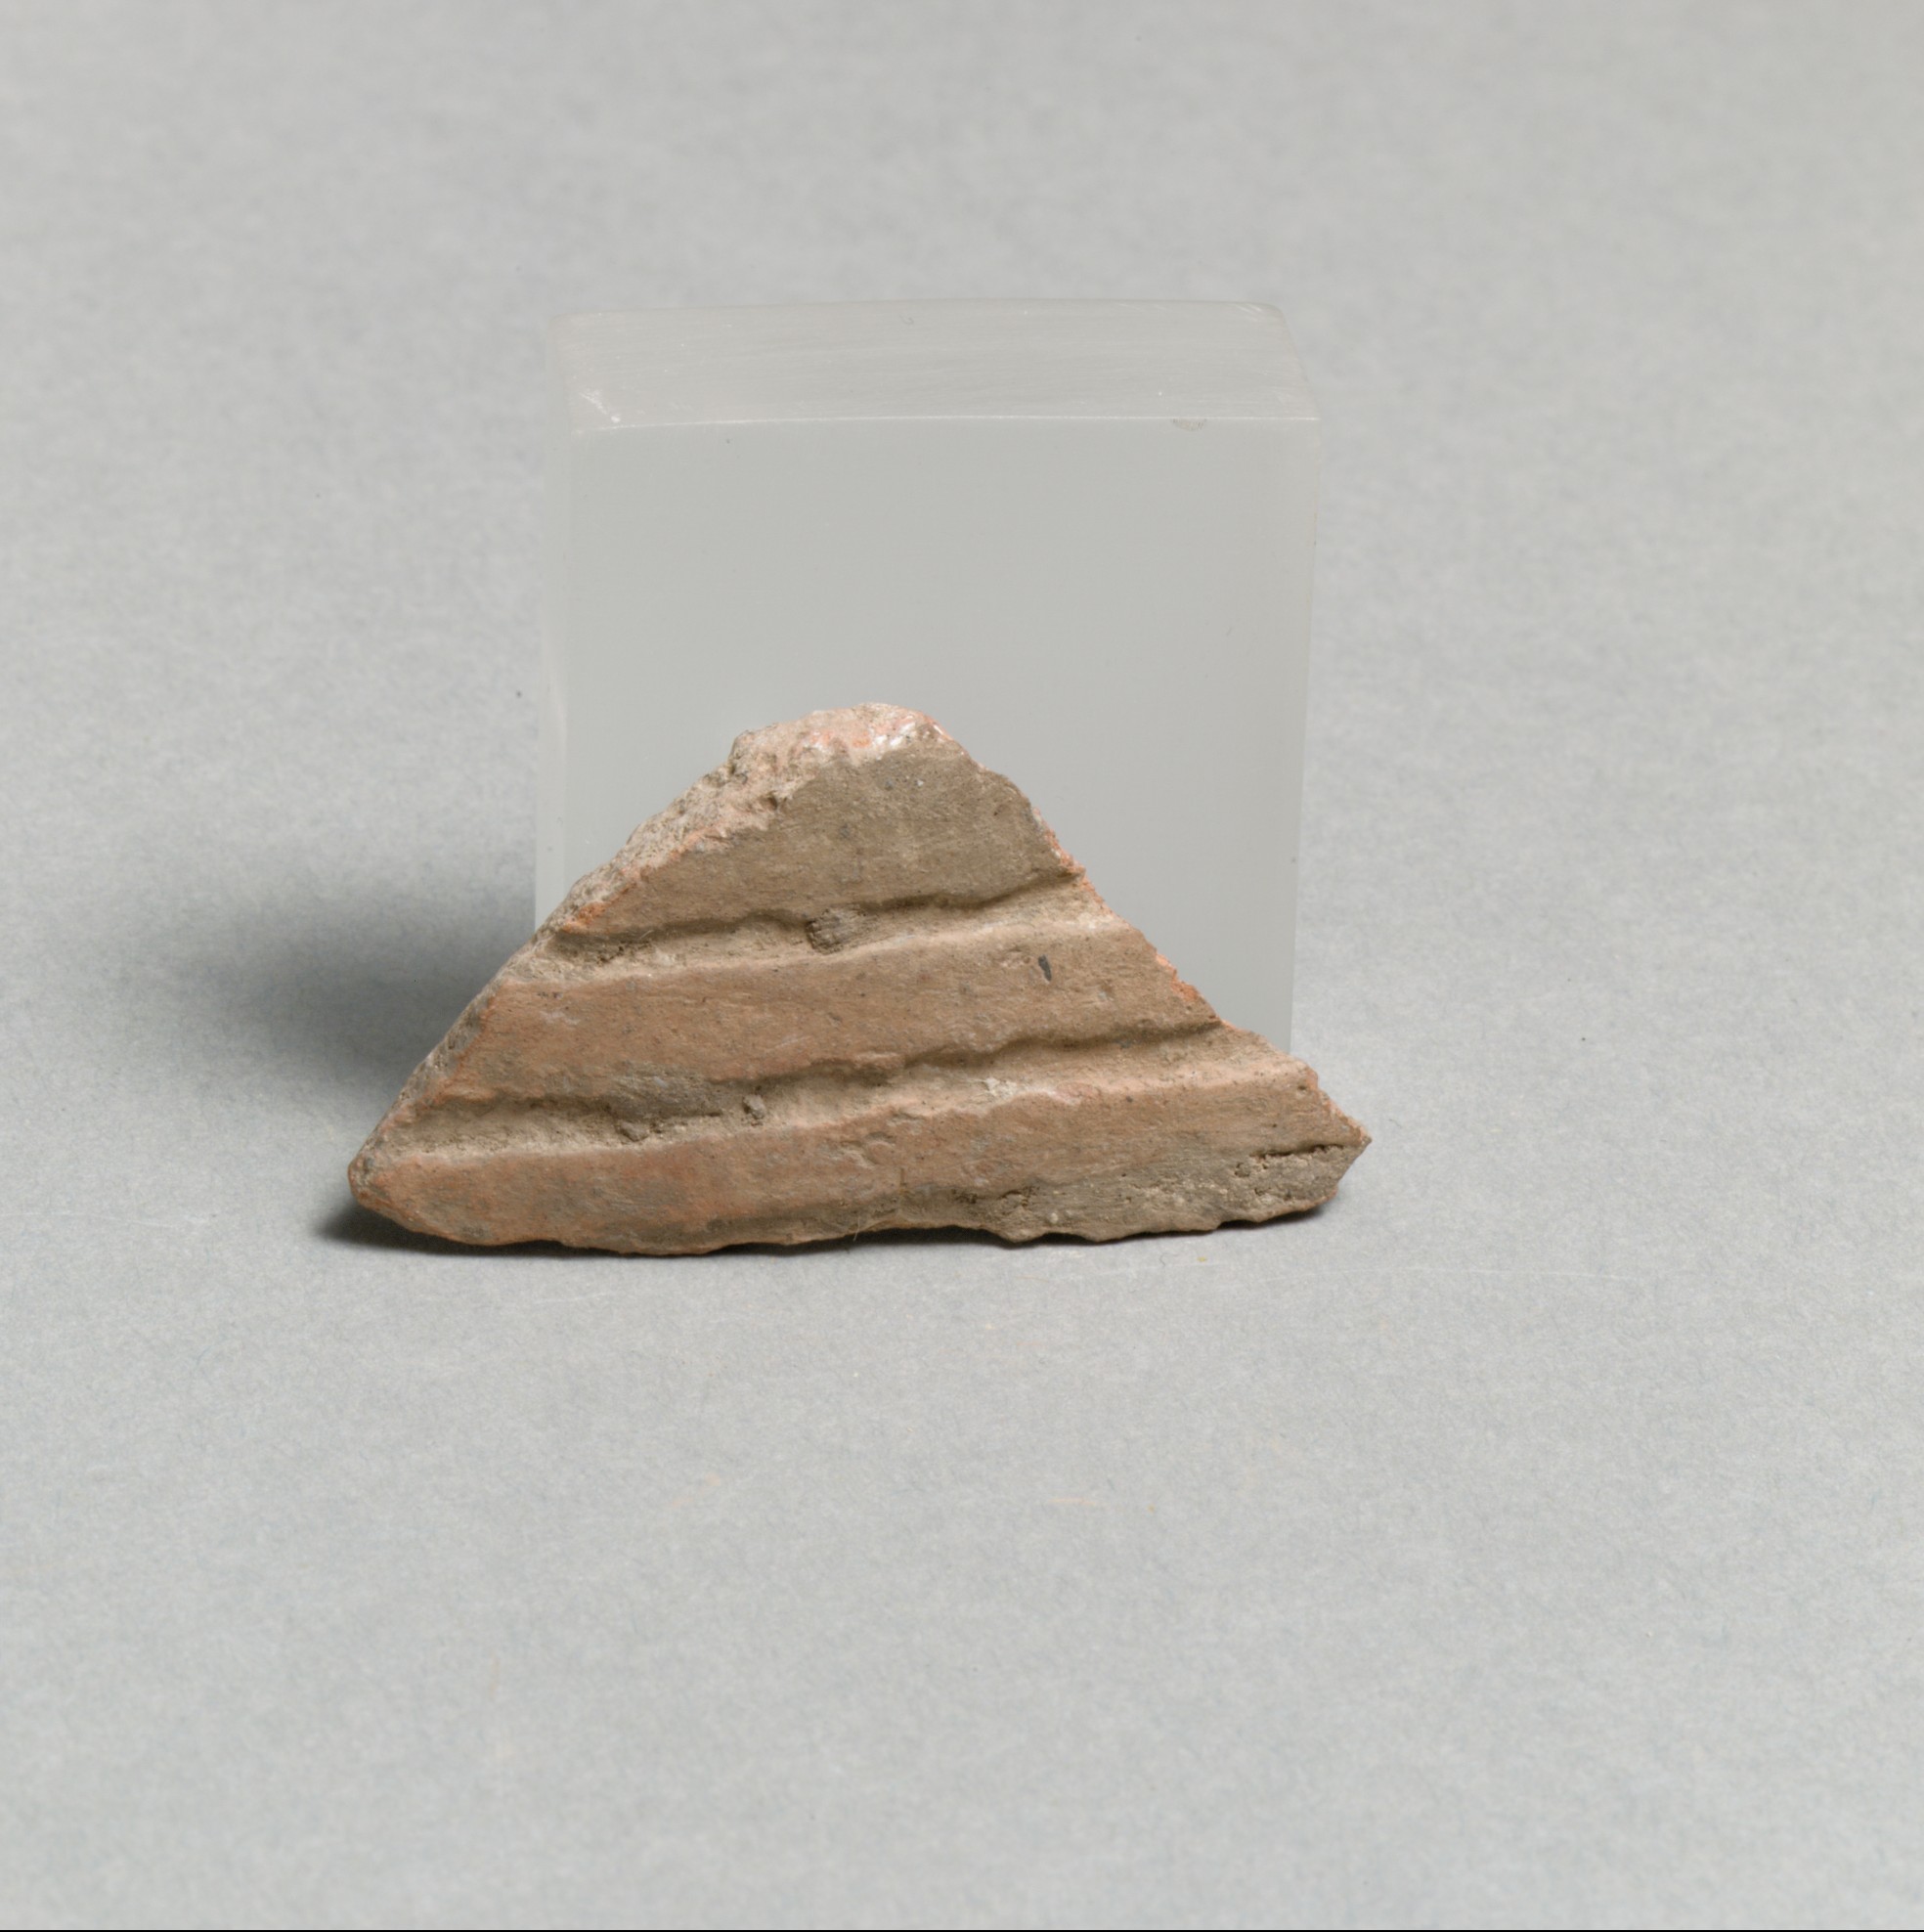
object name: vase fragment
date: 3000-2200 BCE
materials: terracotta